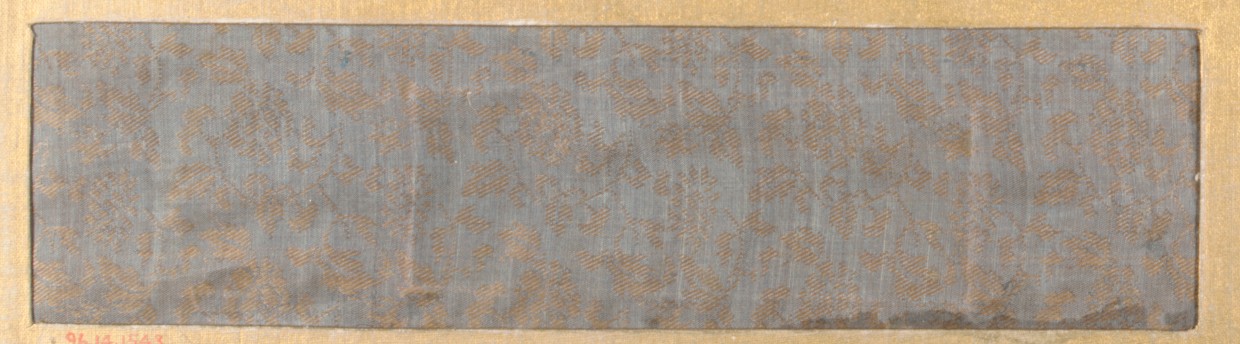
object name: piece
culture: japanese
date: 1701-1900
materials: silk